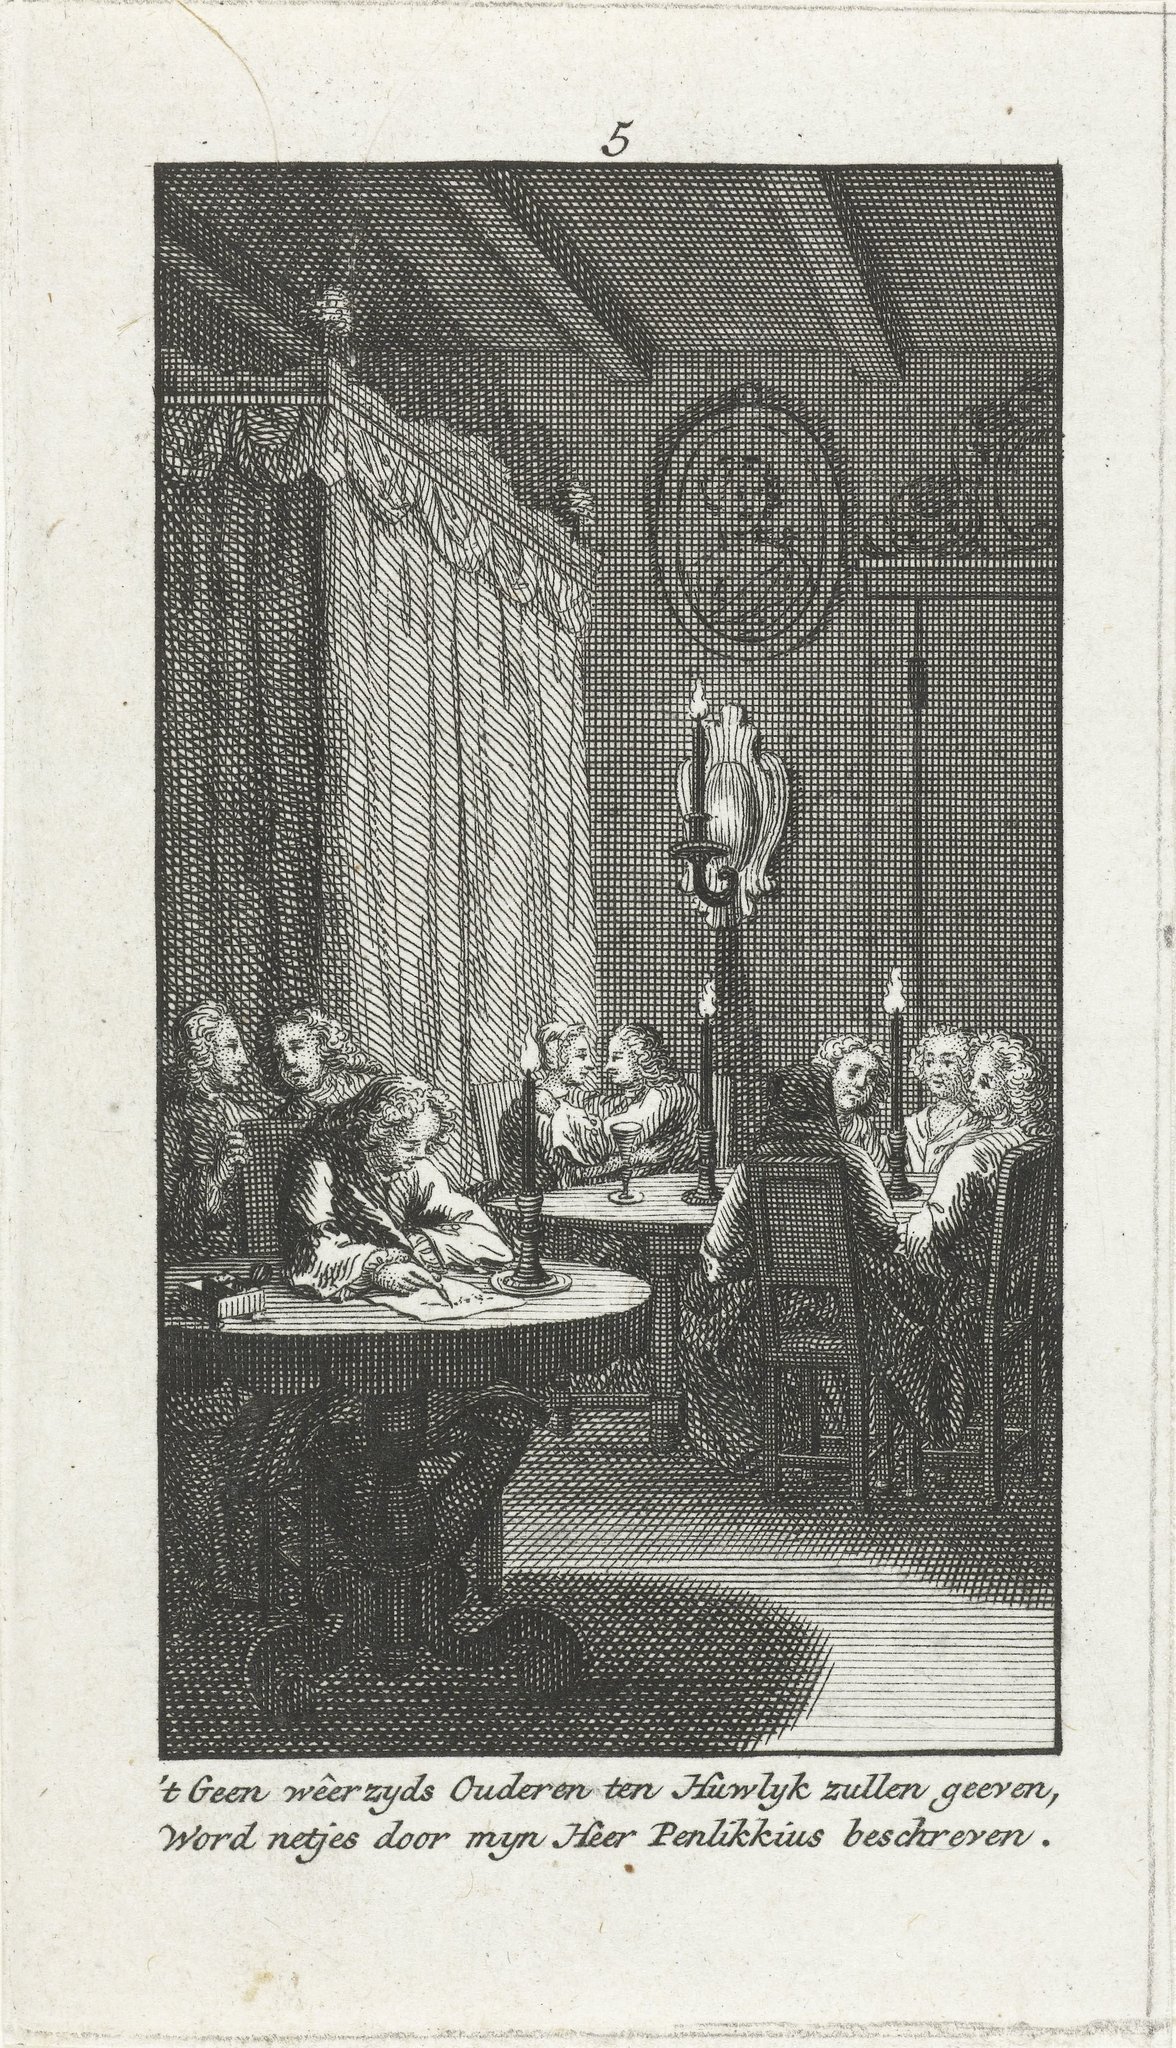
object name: print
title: De ouders laten hun bijdragen vastleggen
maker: jan caspar philips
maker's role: draughtsman, print maker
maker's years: 1700-1775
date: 1740-1760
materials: paper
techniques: engraving, etching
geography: northern netherlands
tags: parental agreement ~ marriage, marriage contract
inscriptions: caption: ‘'t Geen wêerzijds Ouderen ... Heer Penlikkius beschreven.’, collector's mark: Lugt 2228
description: De ouders van het bruidspaar laten hun bijdragen vastleggen. Interieur met minnend paar, hun ouders en op voorgrond schrijvende man. Prent nr. 5 in een serie van twaalf prentjes met tweeregelige versjes over de Hollandse gewoontes bij het huwelijk ca. 1750.